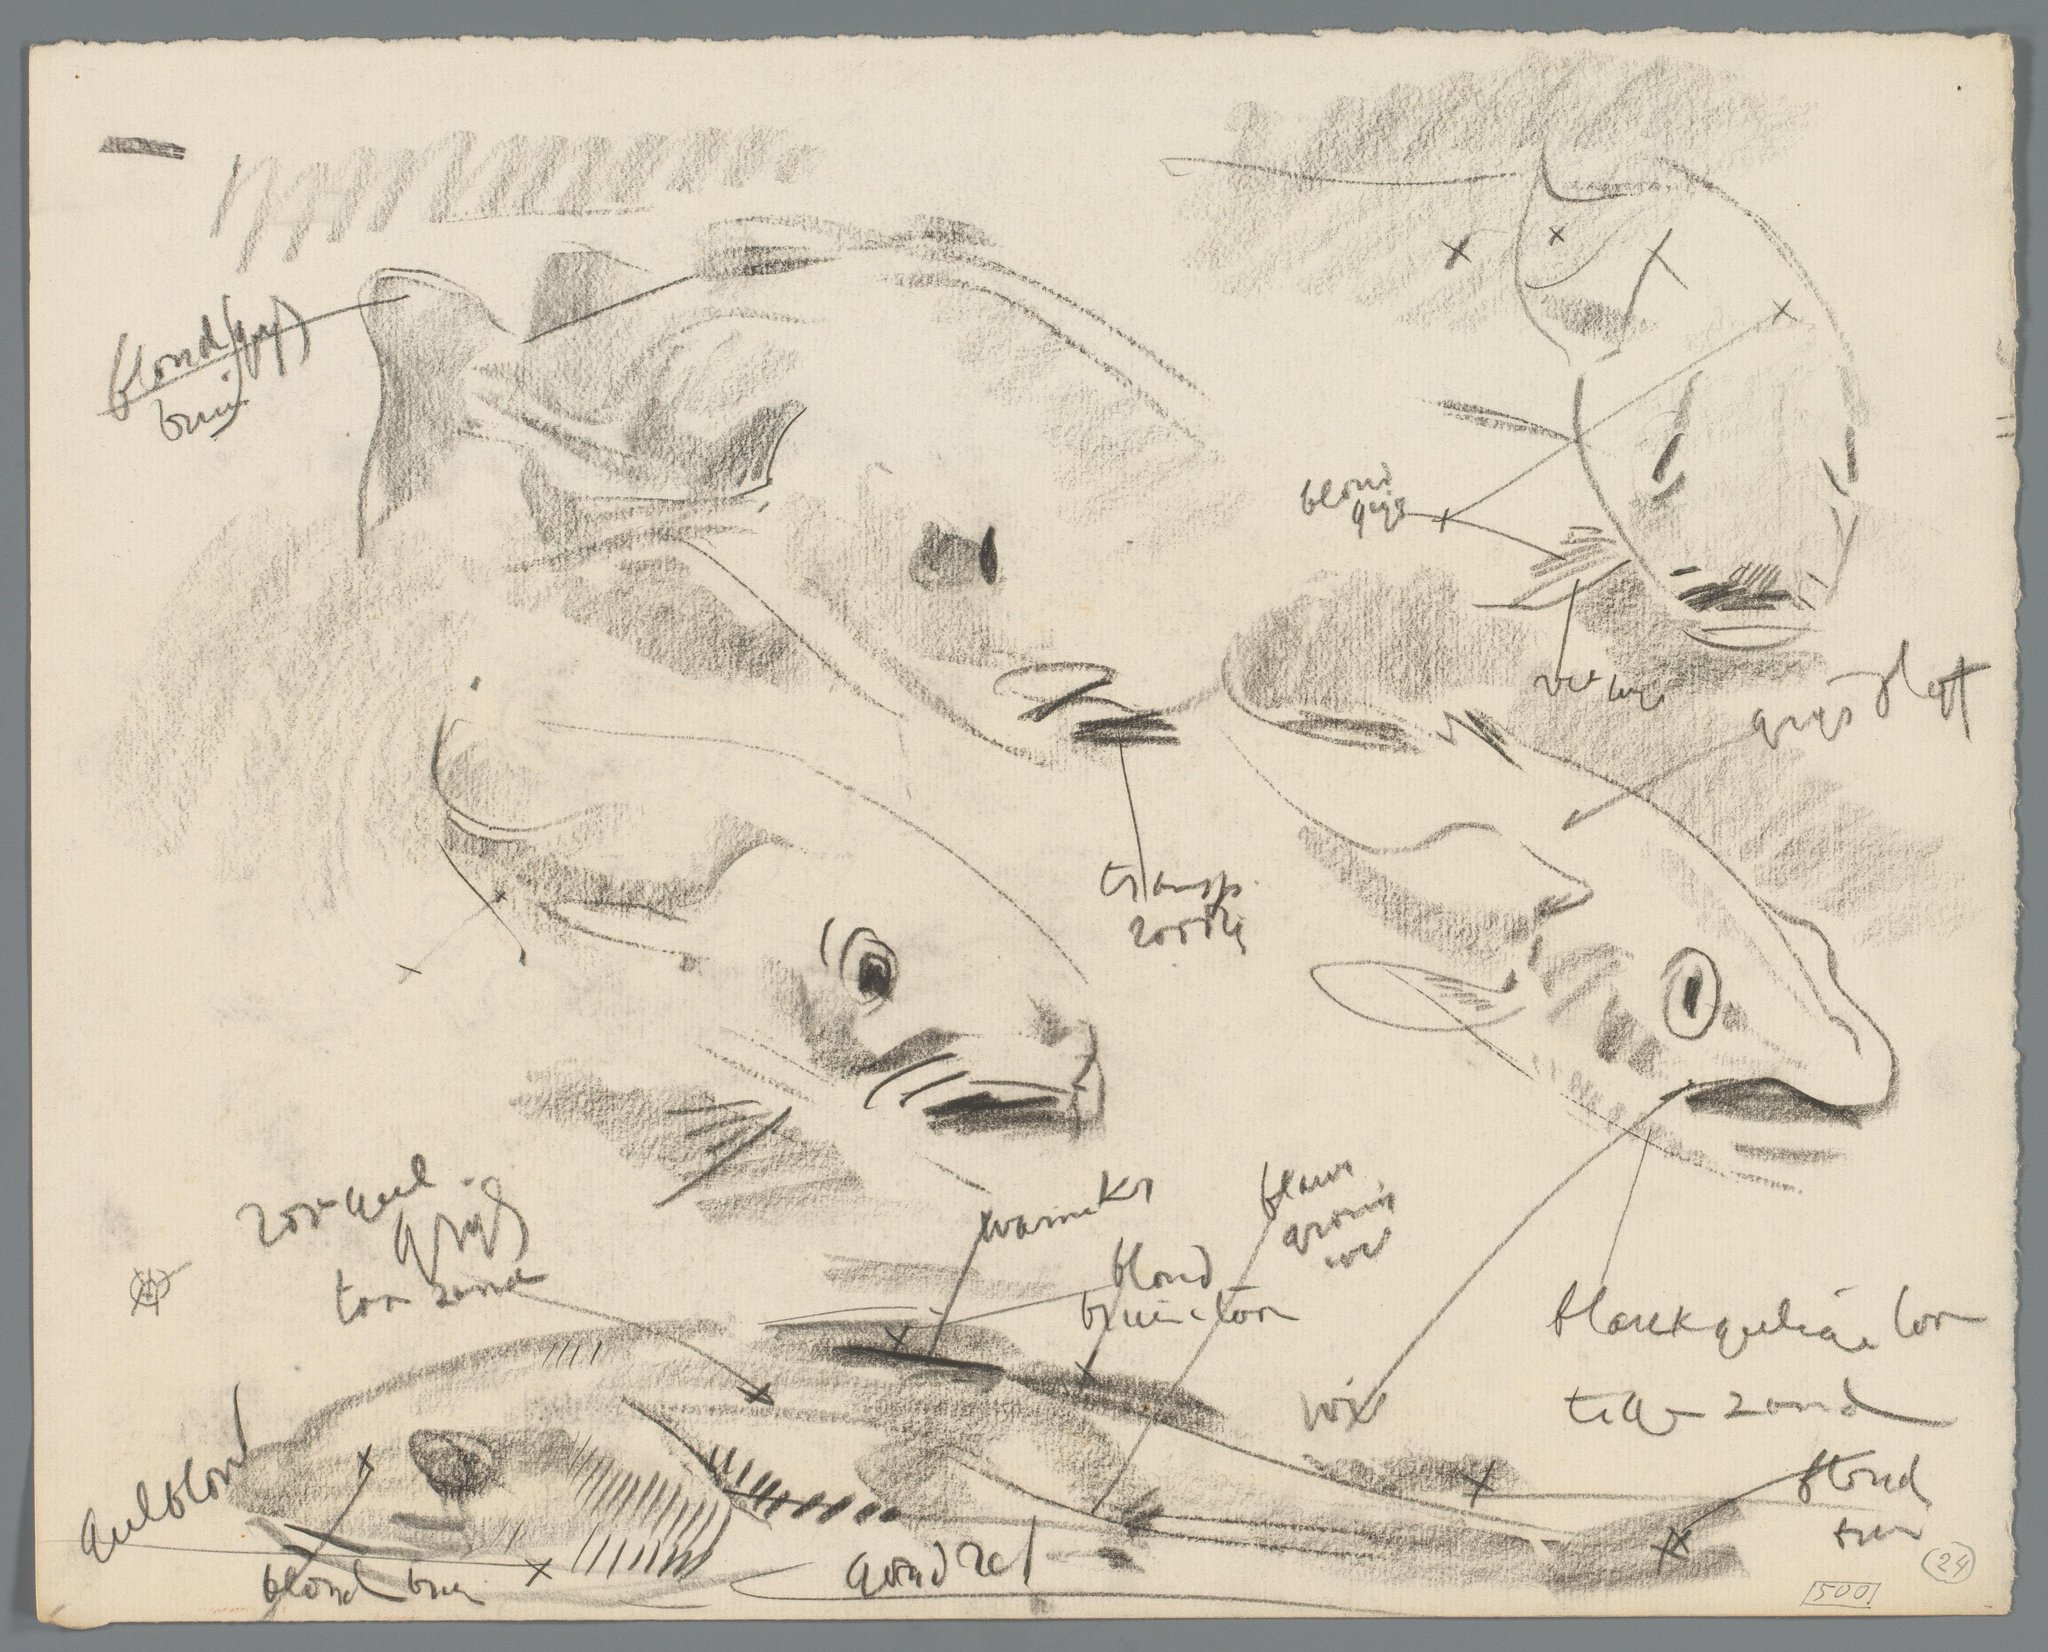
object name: drawing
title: Studies van vissen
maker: gerrit willem dijsselhof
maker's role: designer, draughtsman, print maker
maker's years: 1866-1924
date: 1876-1924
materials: chalk, paper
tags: fishes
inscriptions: number: ‘24’, number: ‘500’